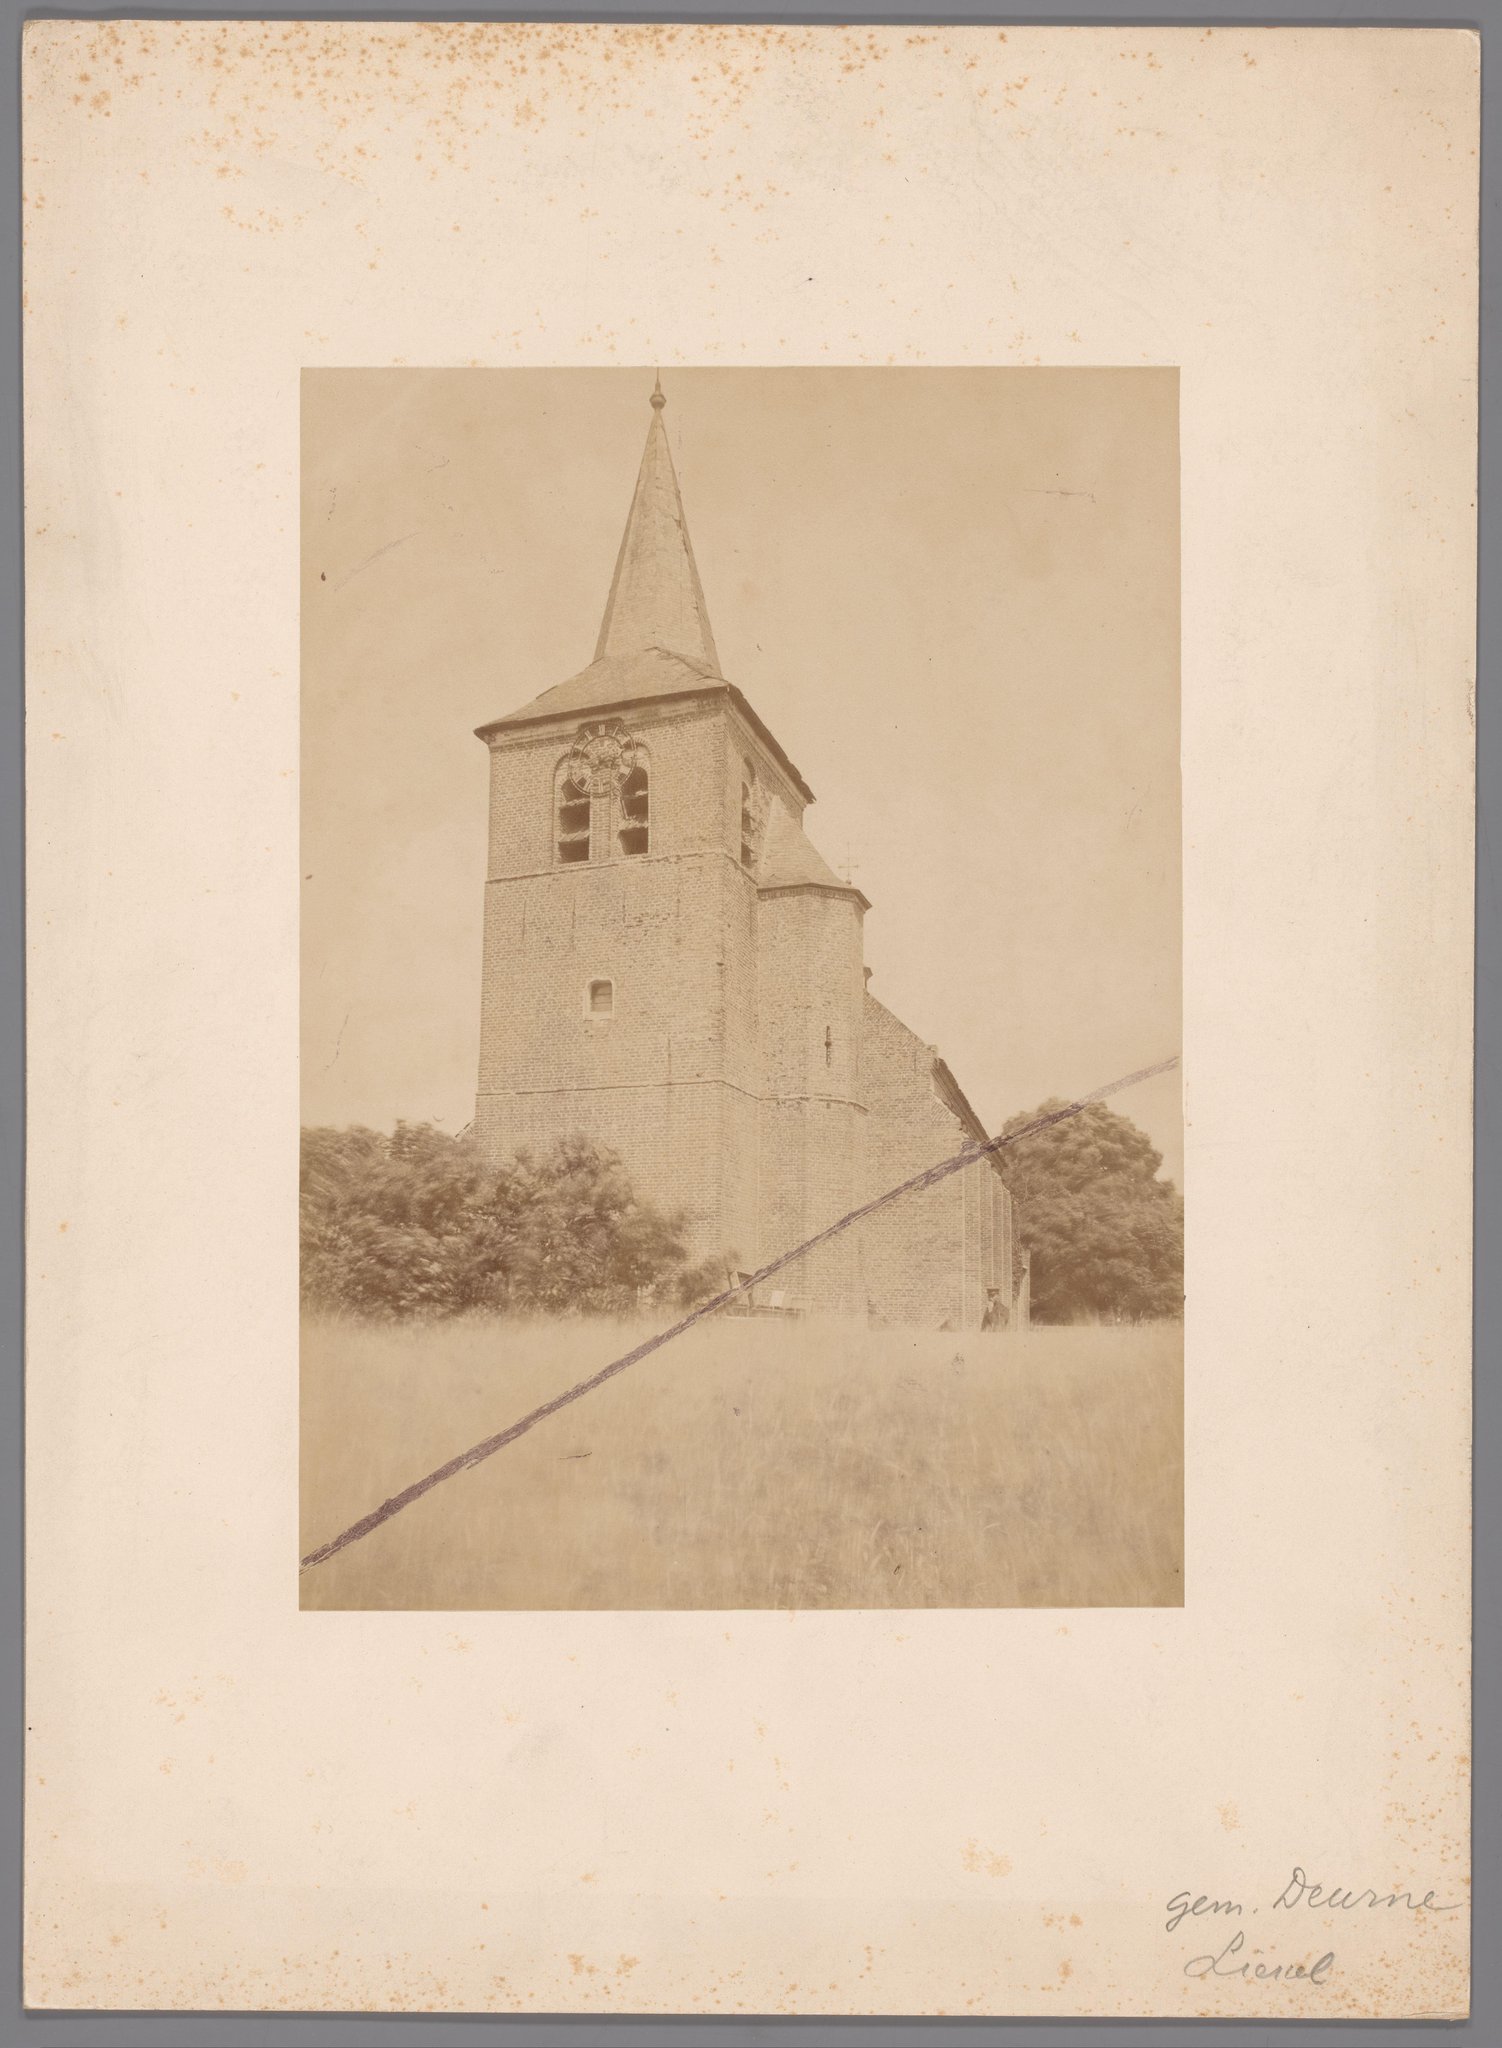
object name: photograph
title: Rooms-katholieke kerk te Liessel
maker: anoniem (monumentenzorg)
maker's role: fotograaf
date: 1901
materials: cardboard, photographic support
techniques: albumen print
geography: liessel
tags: church (exterior)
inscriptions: annotation: ‘gem. Deurne/ Liessel’, annotation: ‘Toren v/d R.K. Kerk te Liessel (N.B.) 1901’